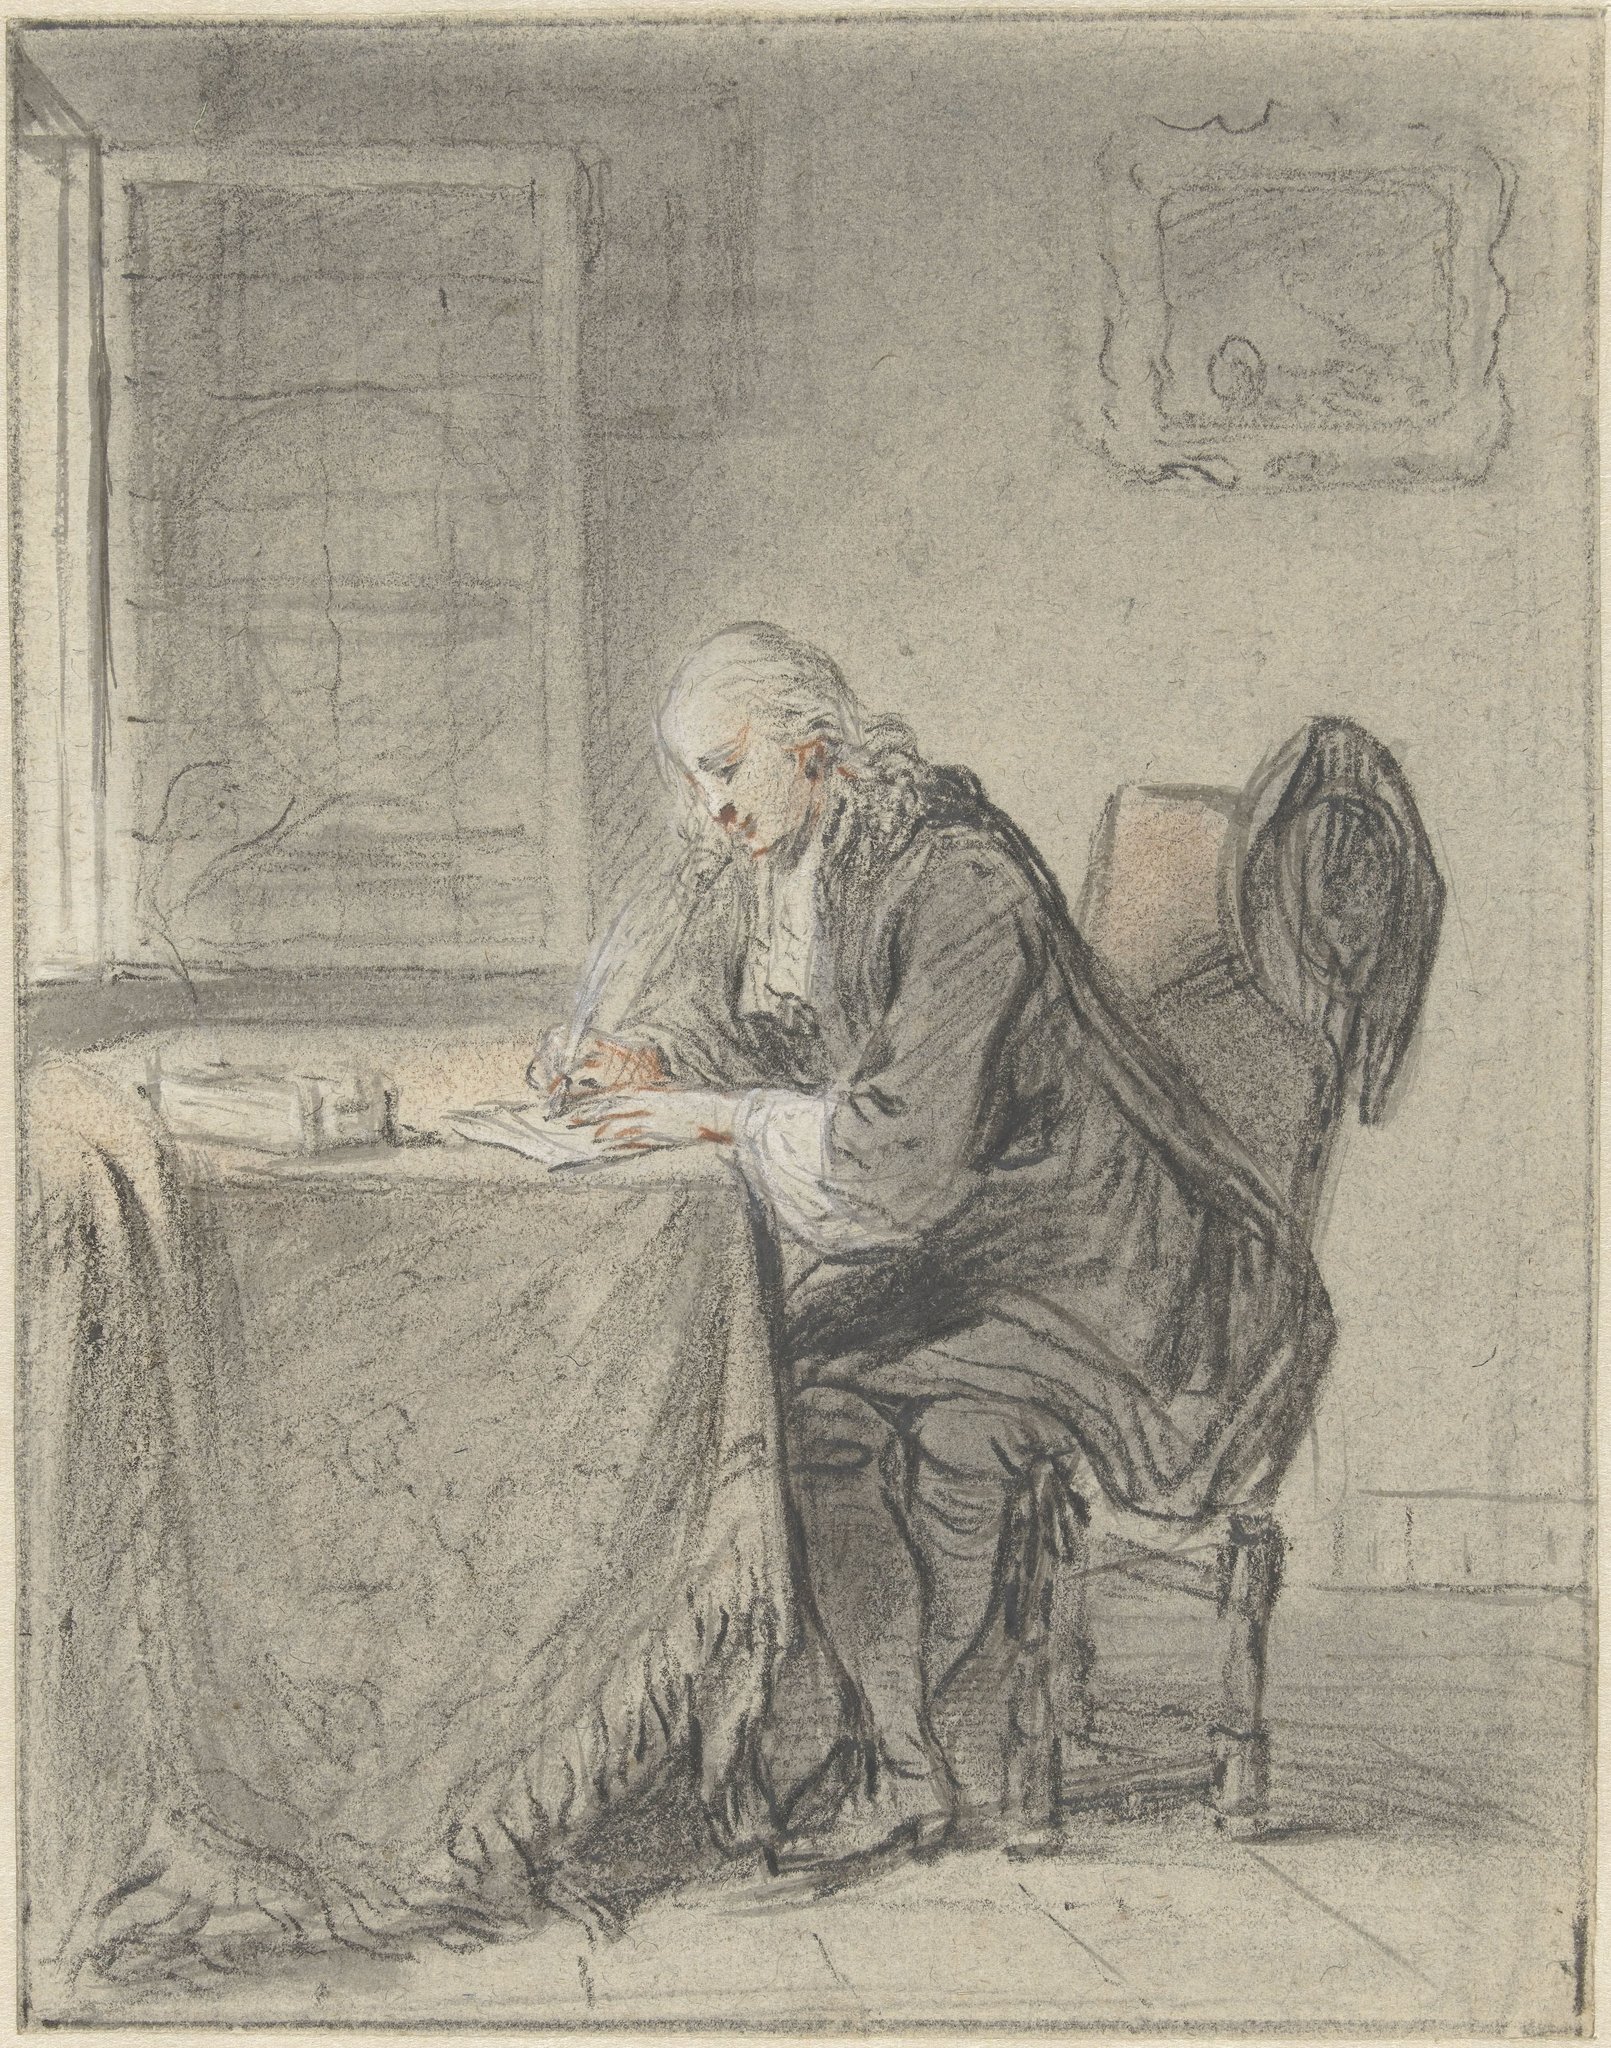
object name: drawing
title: De briefschrijver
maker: willem joseph laquy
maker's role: draughtsman, painter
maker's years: 1738-1798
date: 1748-1798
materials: chalk, paper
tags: handwriting, writing as activity